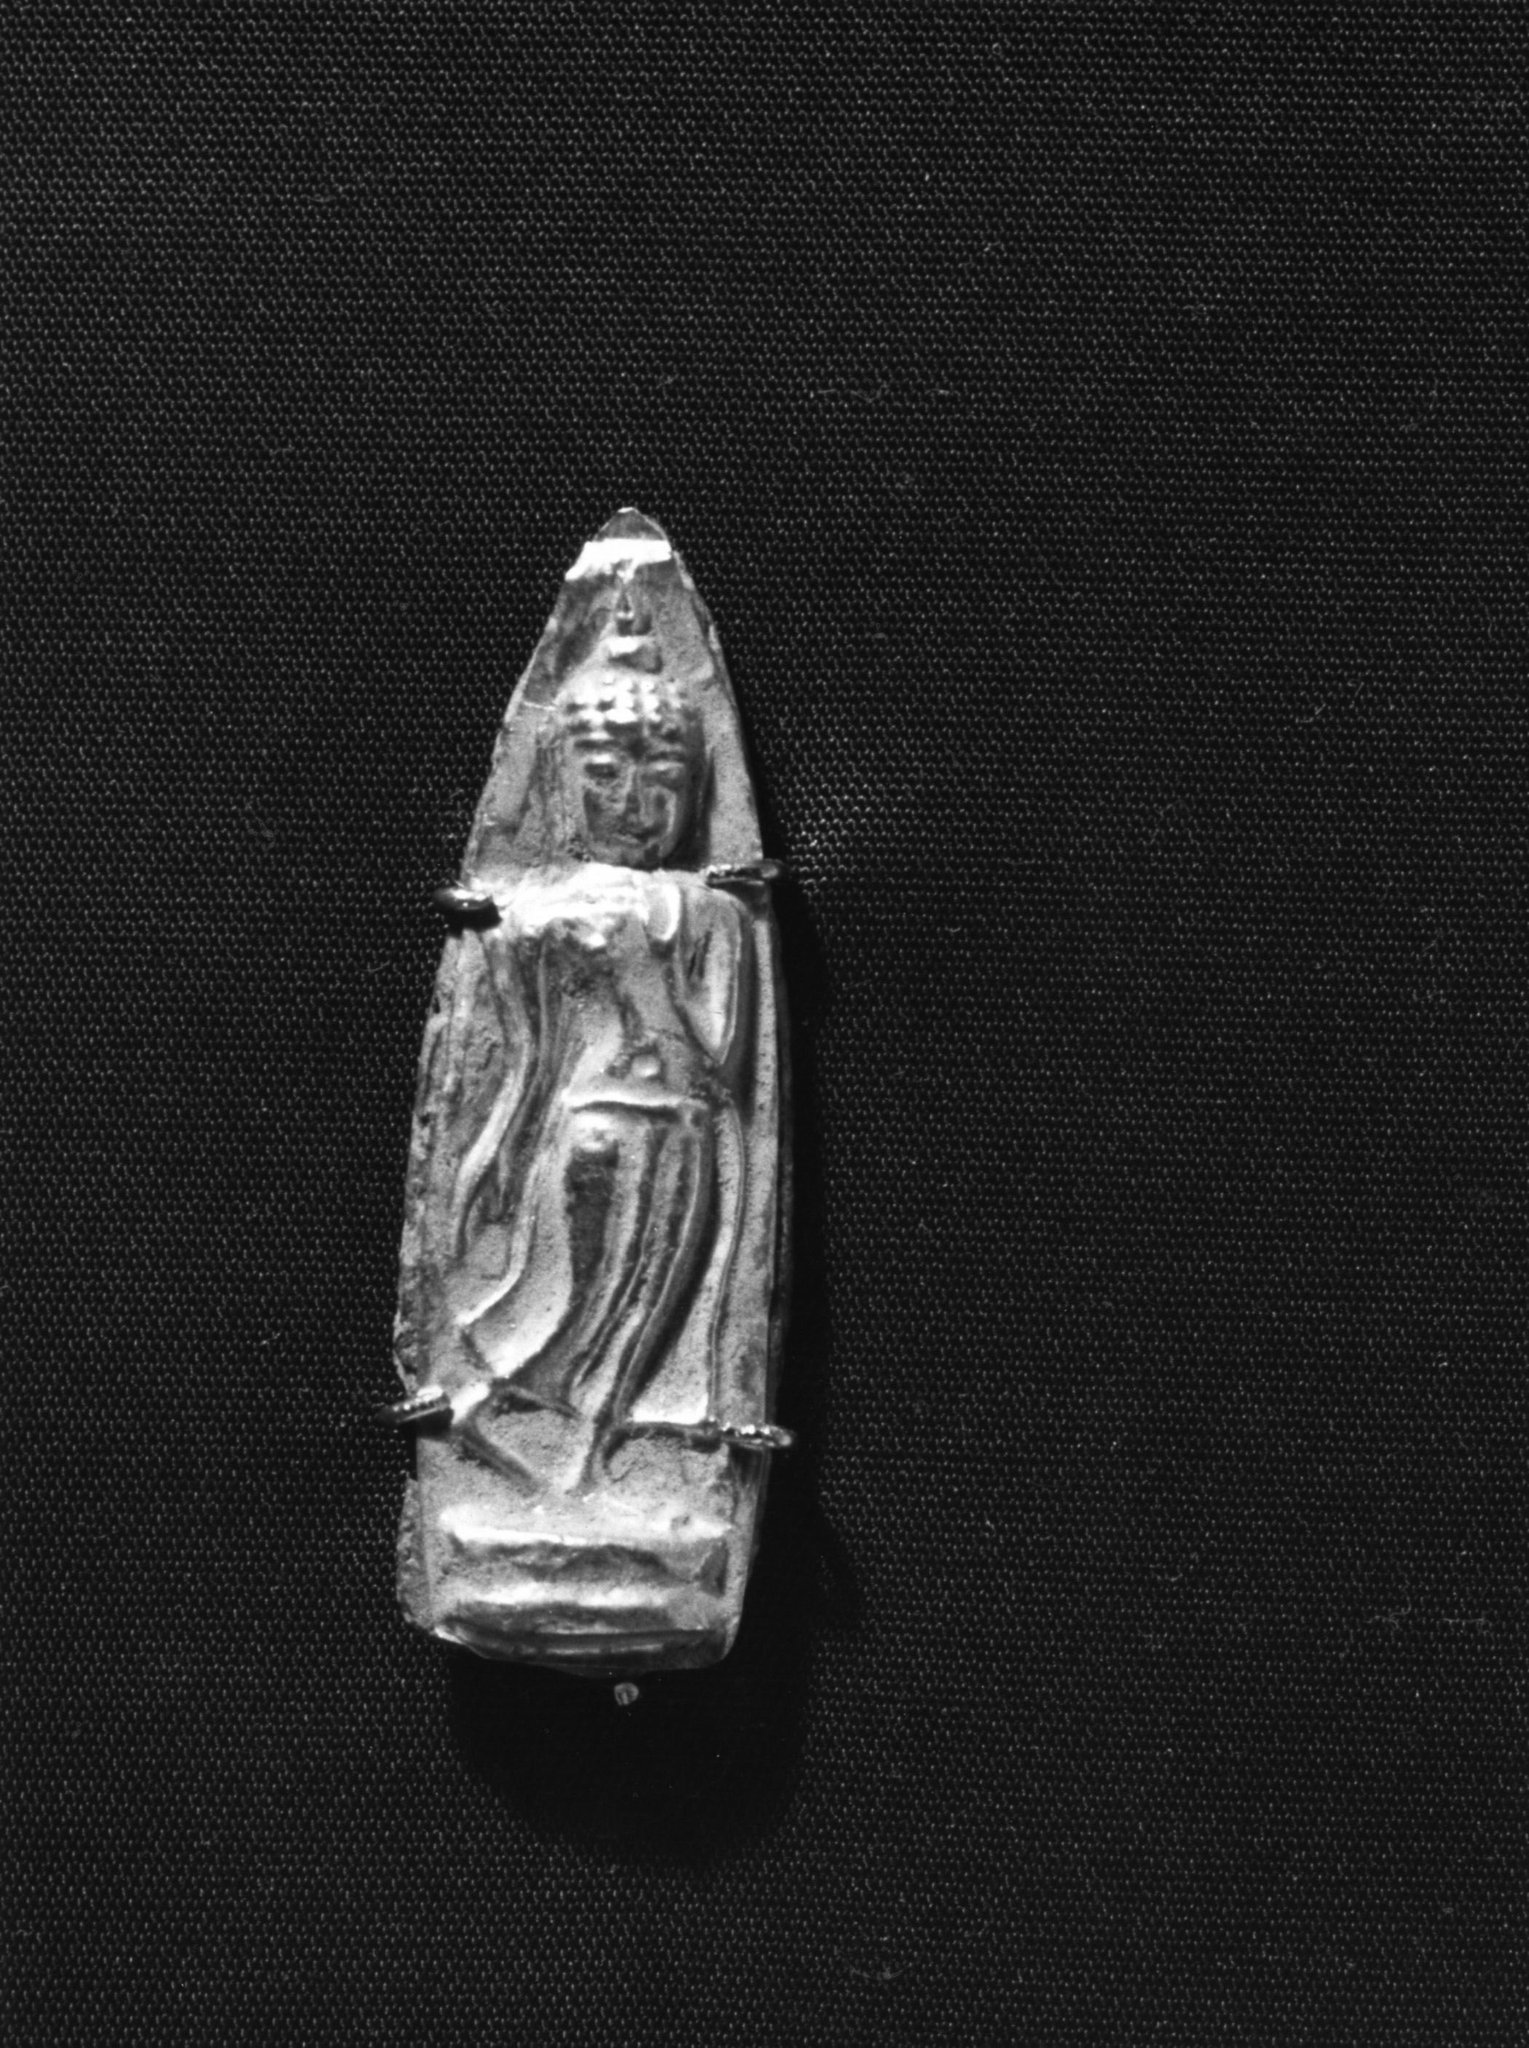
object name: plaque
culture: thai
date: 1301-1500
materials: gold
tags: buddhism,buddha